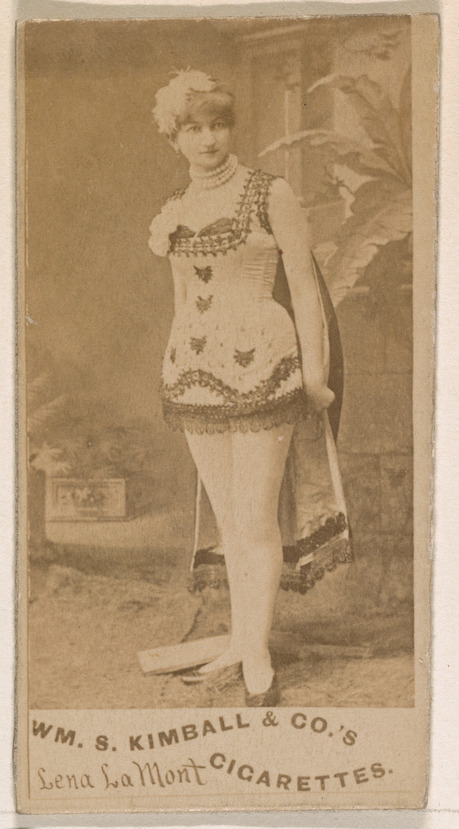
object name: photograph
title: Lena La Mont, from the Actresses series (N203) issued by Wm. S. Kimball & Co.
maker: william s. kimball & company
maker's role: publisher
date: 1889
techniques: color lithograph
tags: portraits,women,actresses